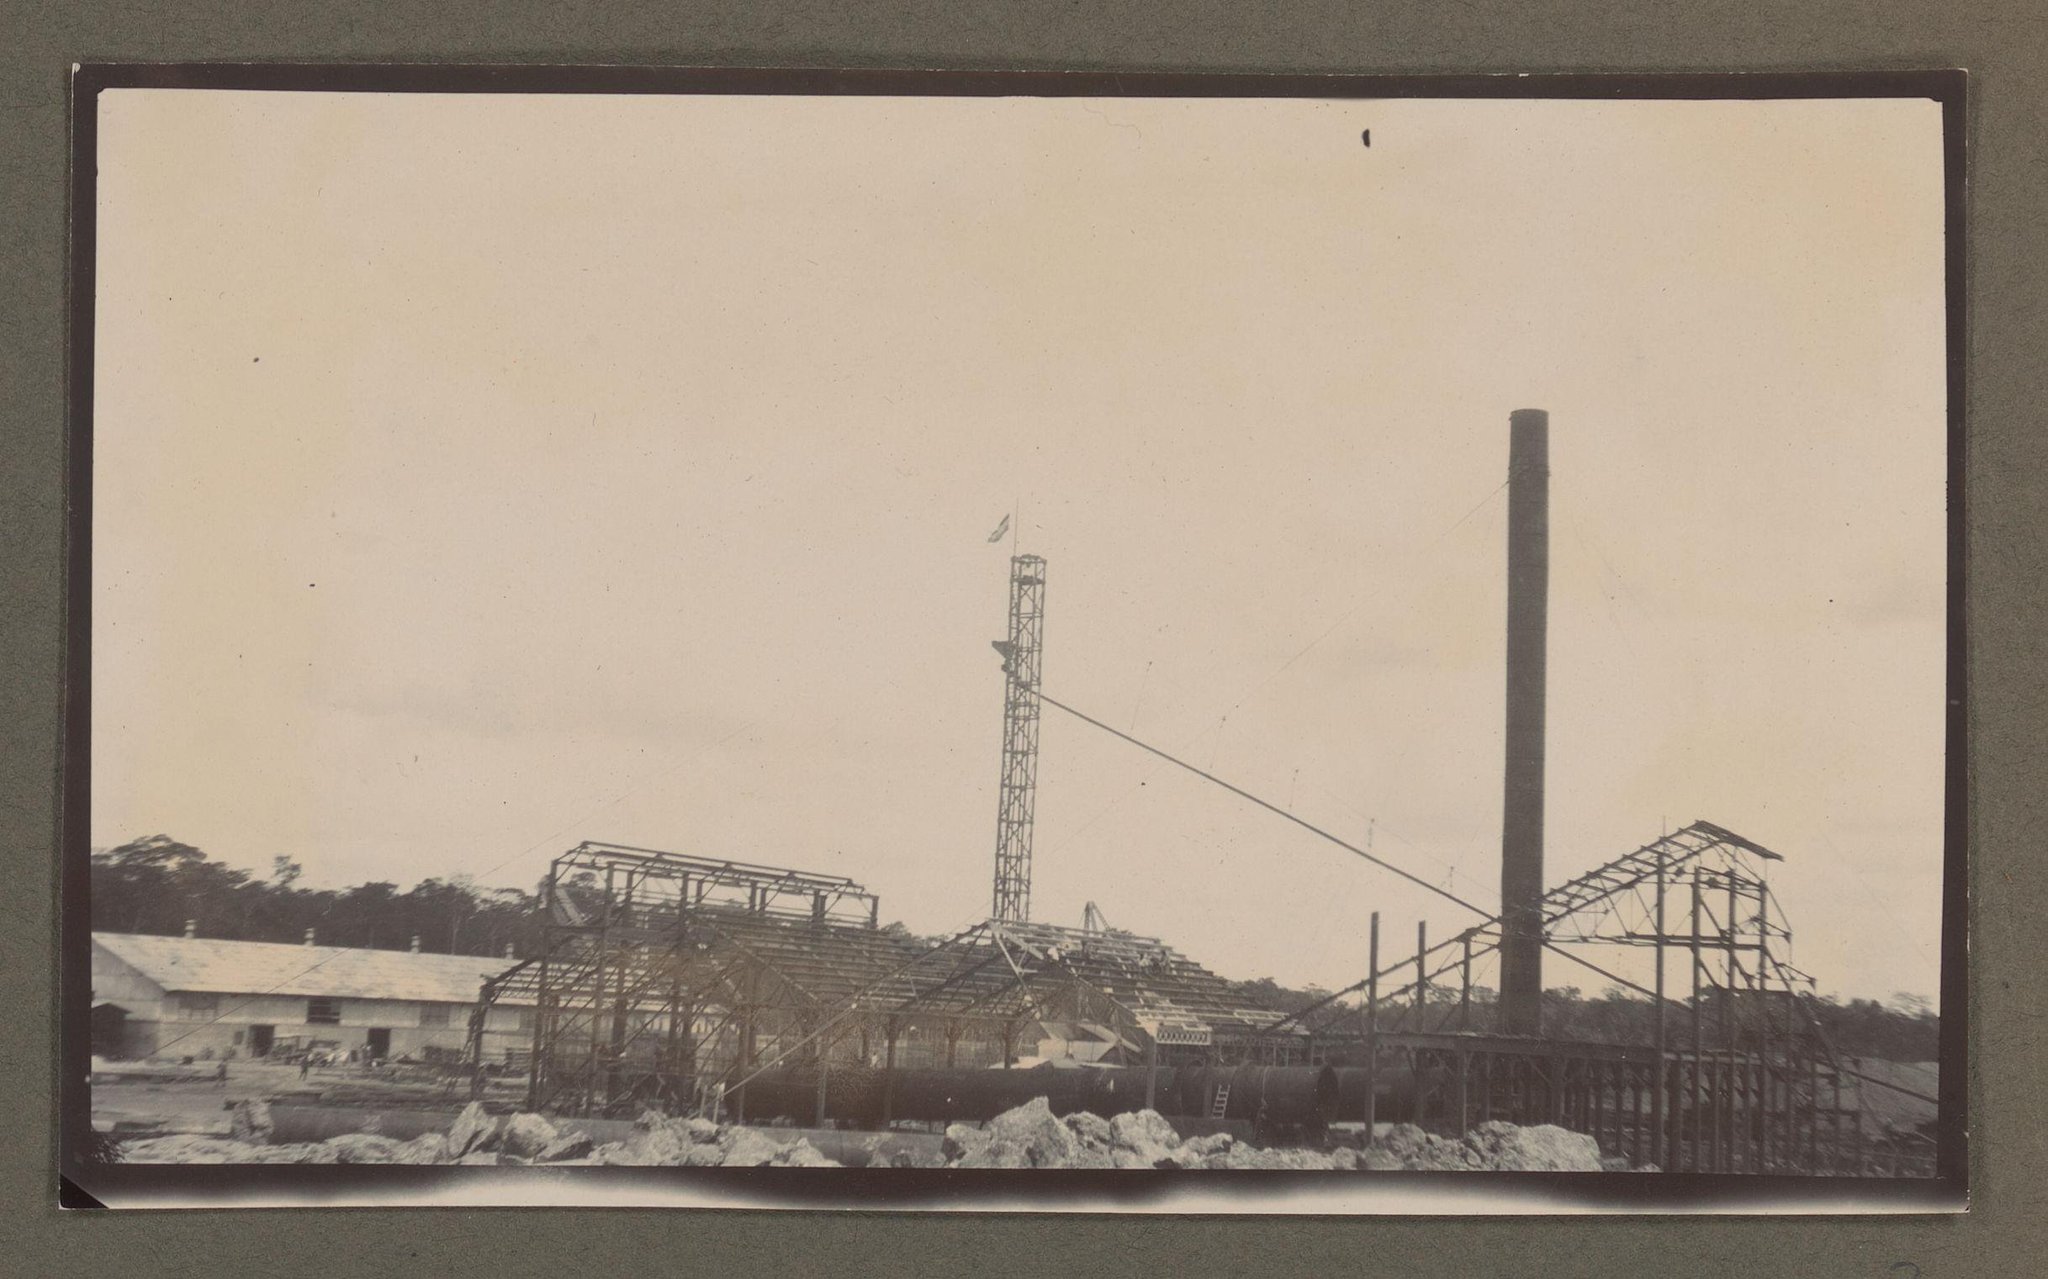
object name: photograph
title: Mijn en fabriek in Moengo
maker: Anonymous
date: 1925-1927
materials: photographic support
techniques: photography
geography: suriname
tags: jetten, familie, moengo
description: Terrein van de mijn en fabriek in Moengo. Foto op een bladzijde van een los albumblad. Onderdeel van het ensemble met foto's van de familie van ingenieur Jetten in de mijnbouwstad Moengo in Suriname.